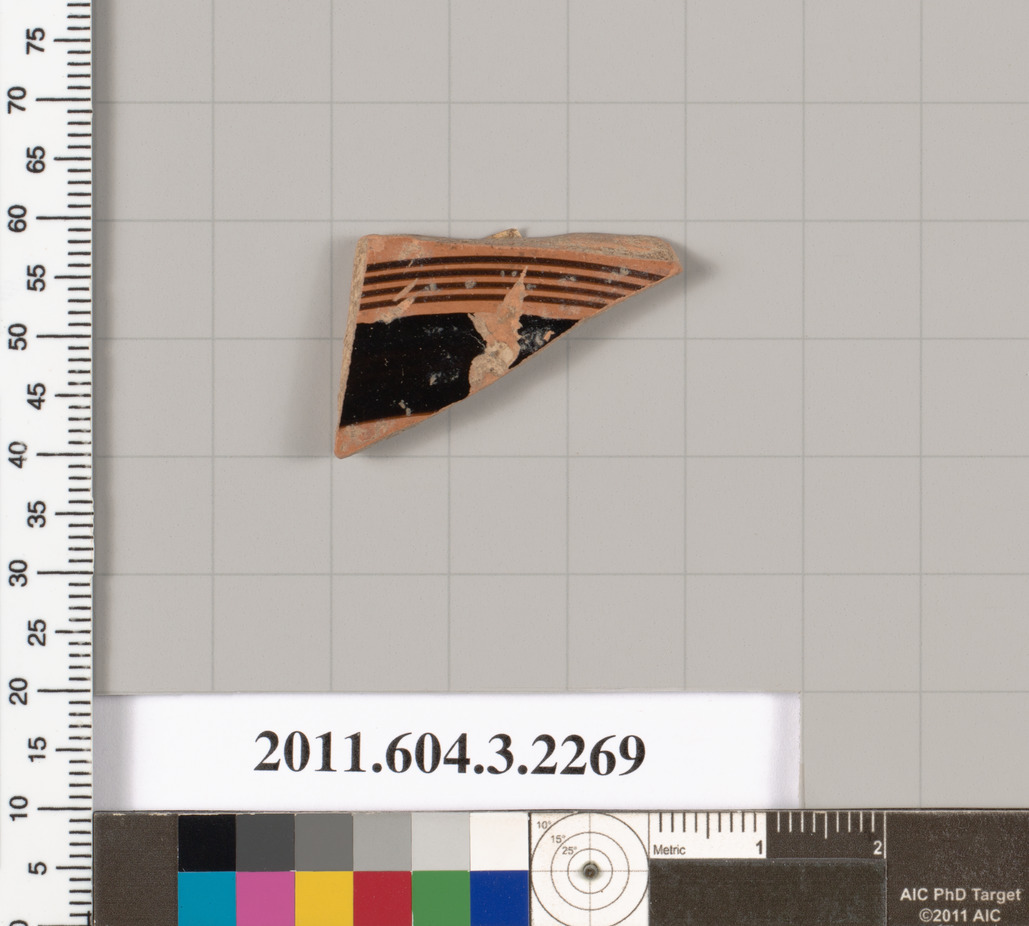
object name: kylix fragment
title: Terracotta fragment of a kylix (drinking cup)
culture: greek, attic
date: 600-401 BCE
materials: terracotta